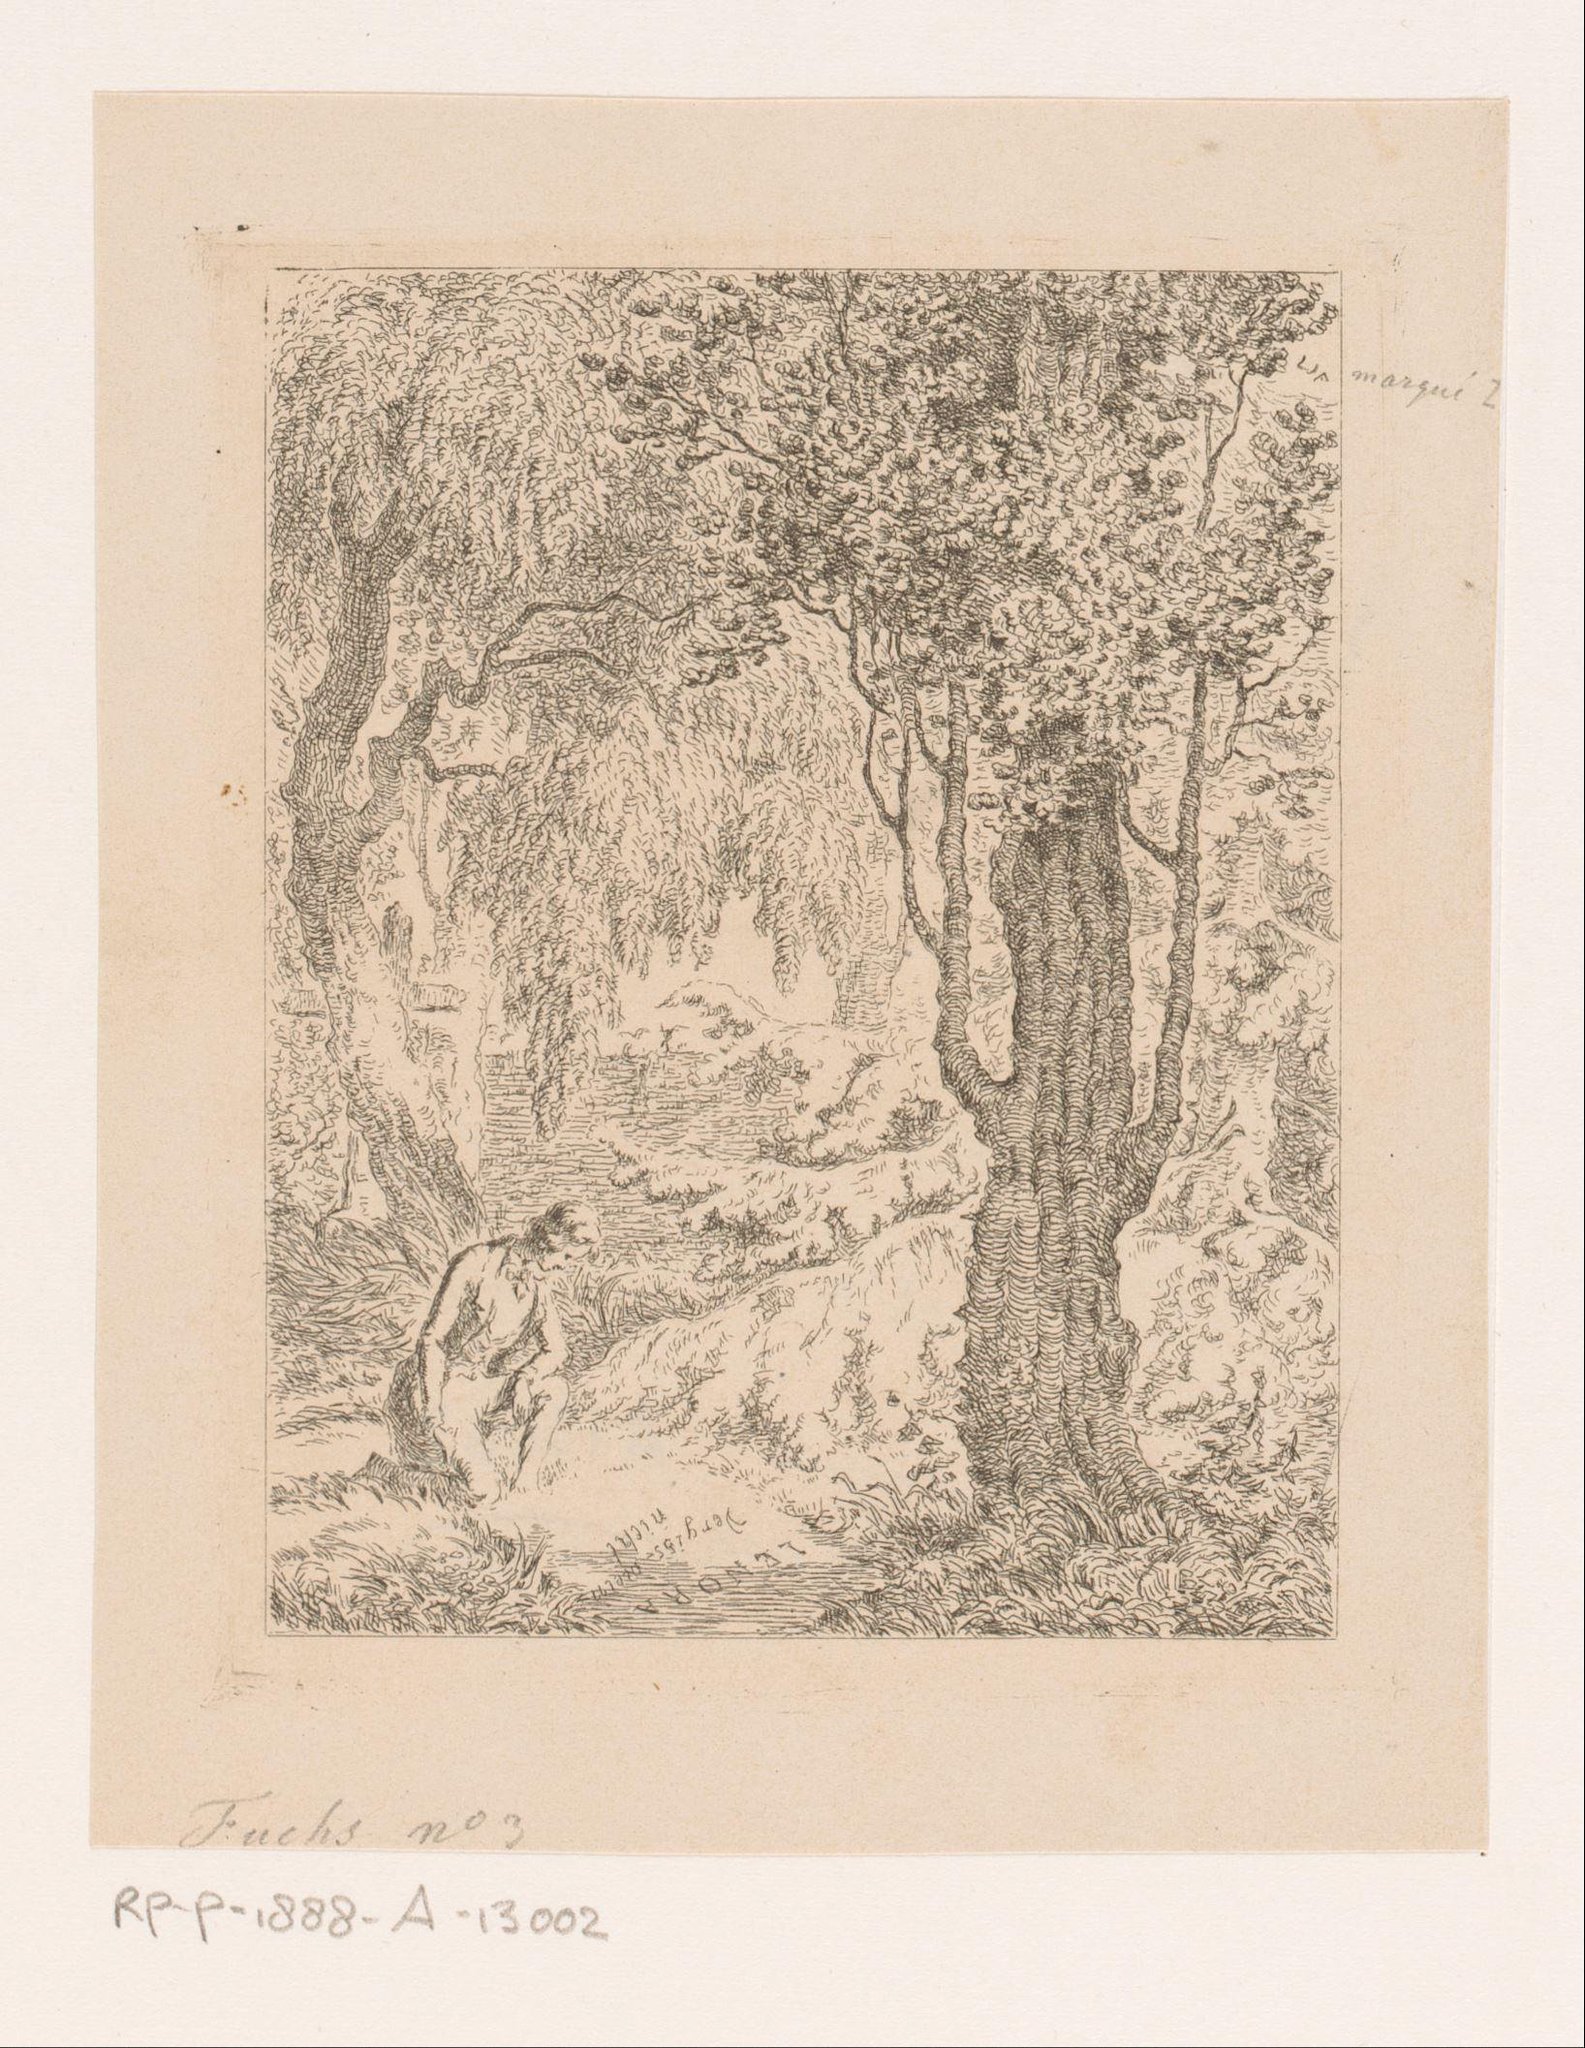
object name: print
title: Man knielt in een bos bij een herdenkingsplaats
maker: lodewijk juliaan fuchs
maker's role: print maker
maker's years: 1814-1873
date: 1824-1873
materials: paper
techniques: etching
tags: forest, wood, kneeling figure, grave, tomb and other grave-forms and grave-markers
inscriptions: collector's mark: Lugt 2228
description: Op de openplek in het bos bij de knielende man staat: 'Lenora, vergiss mein nicht'.